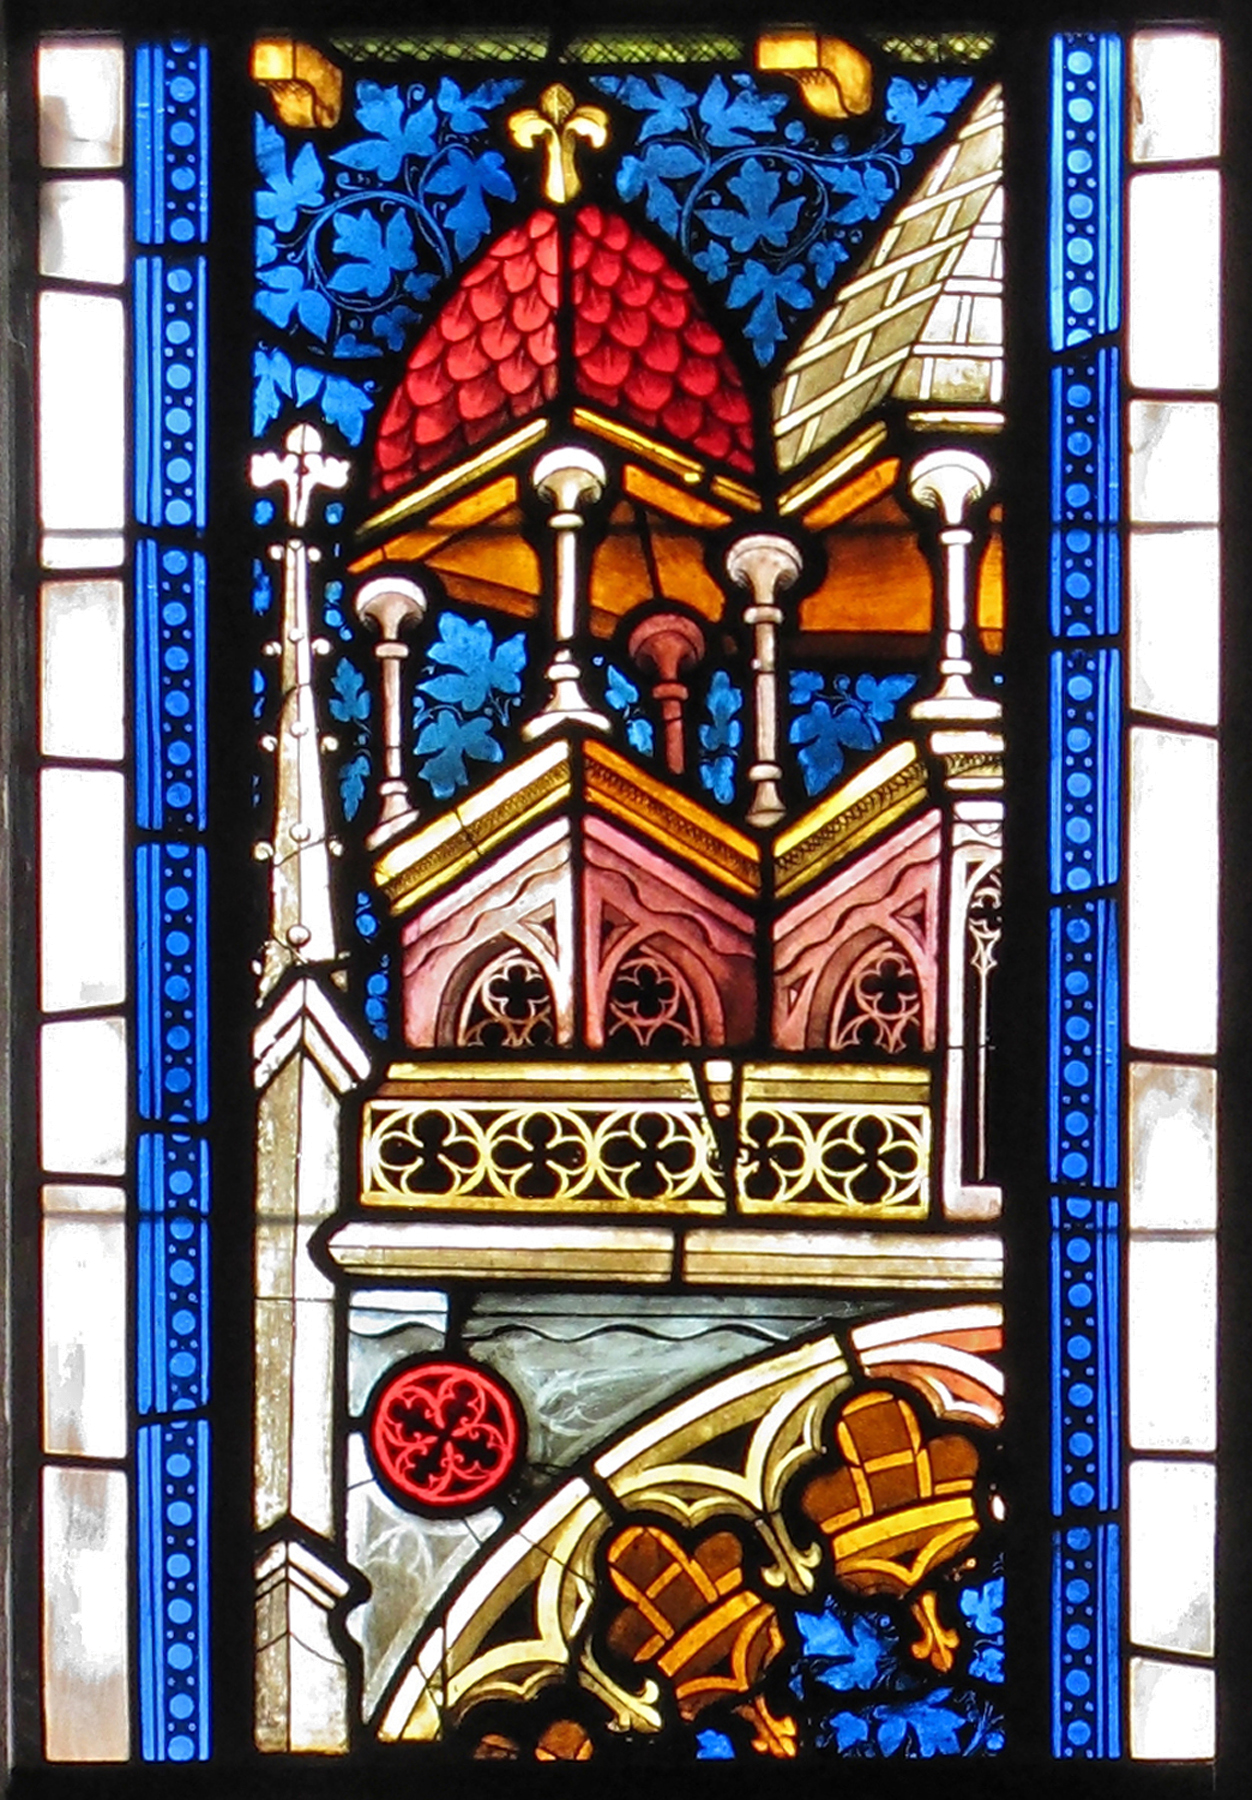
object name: panel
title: Architectural canopy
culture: austrian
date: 1390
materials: glass, metal, paint, pigment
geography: austria